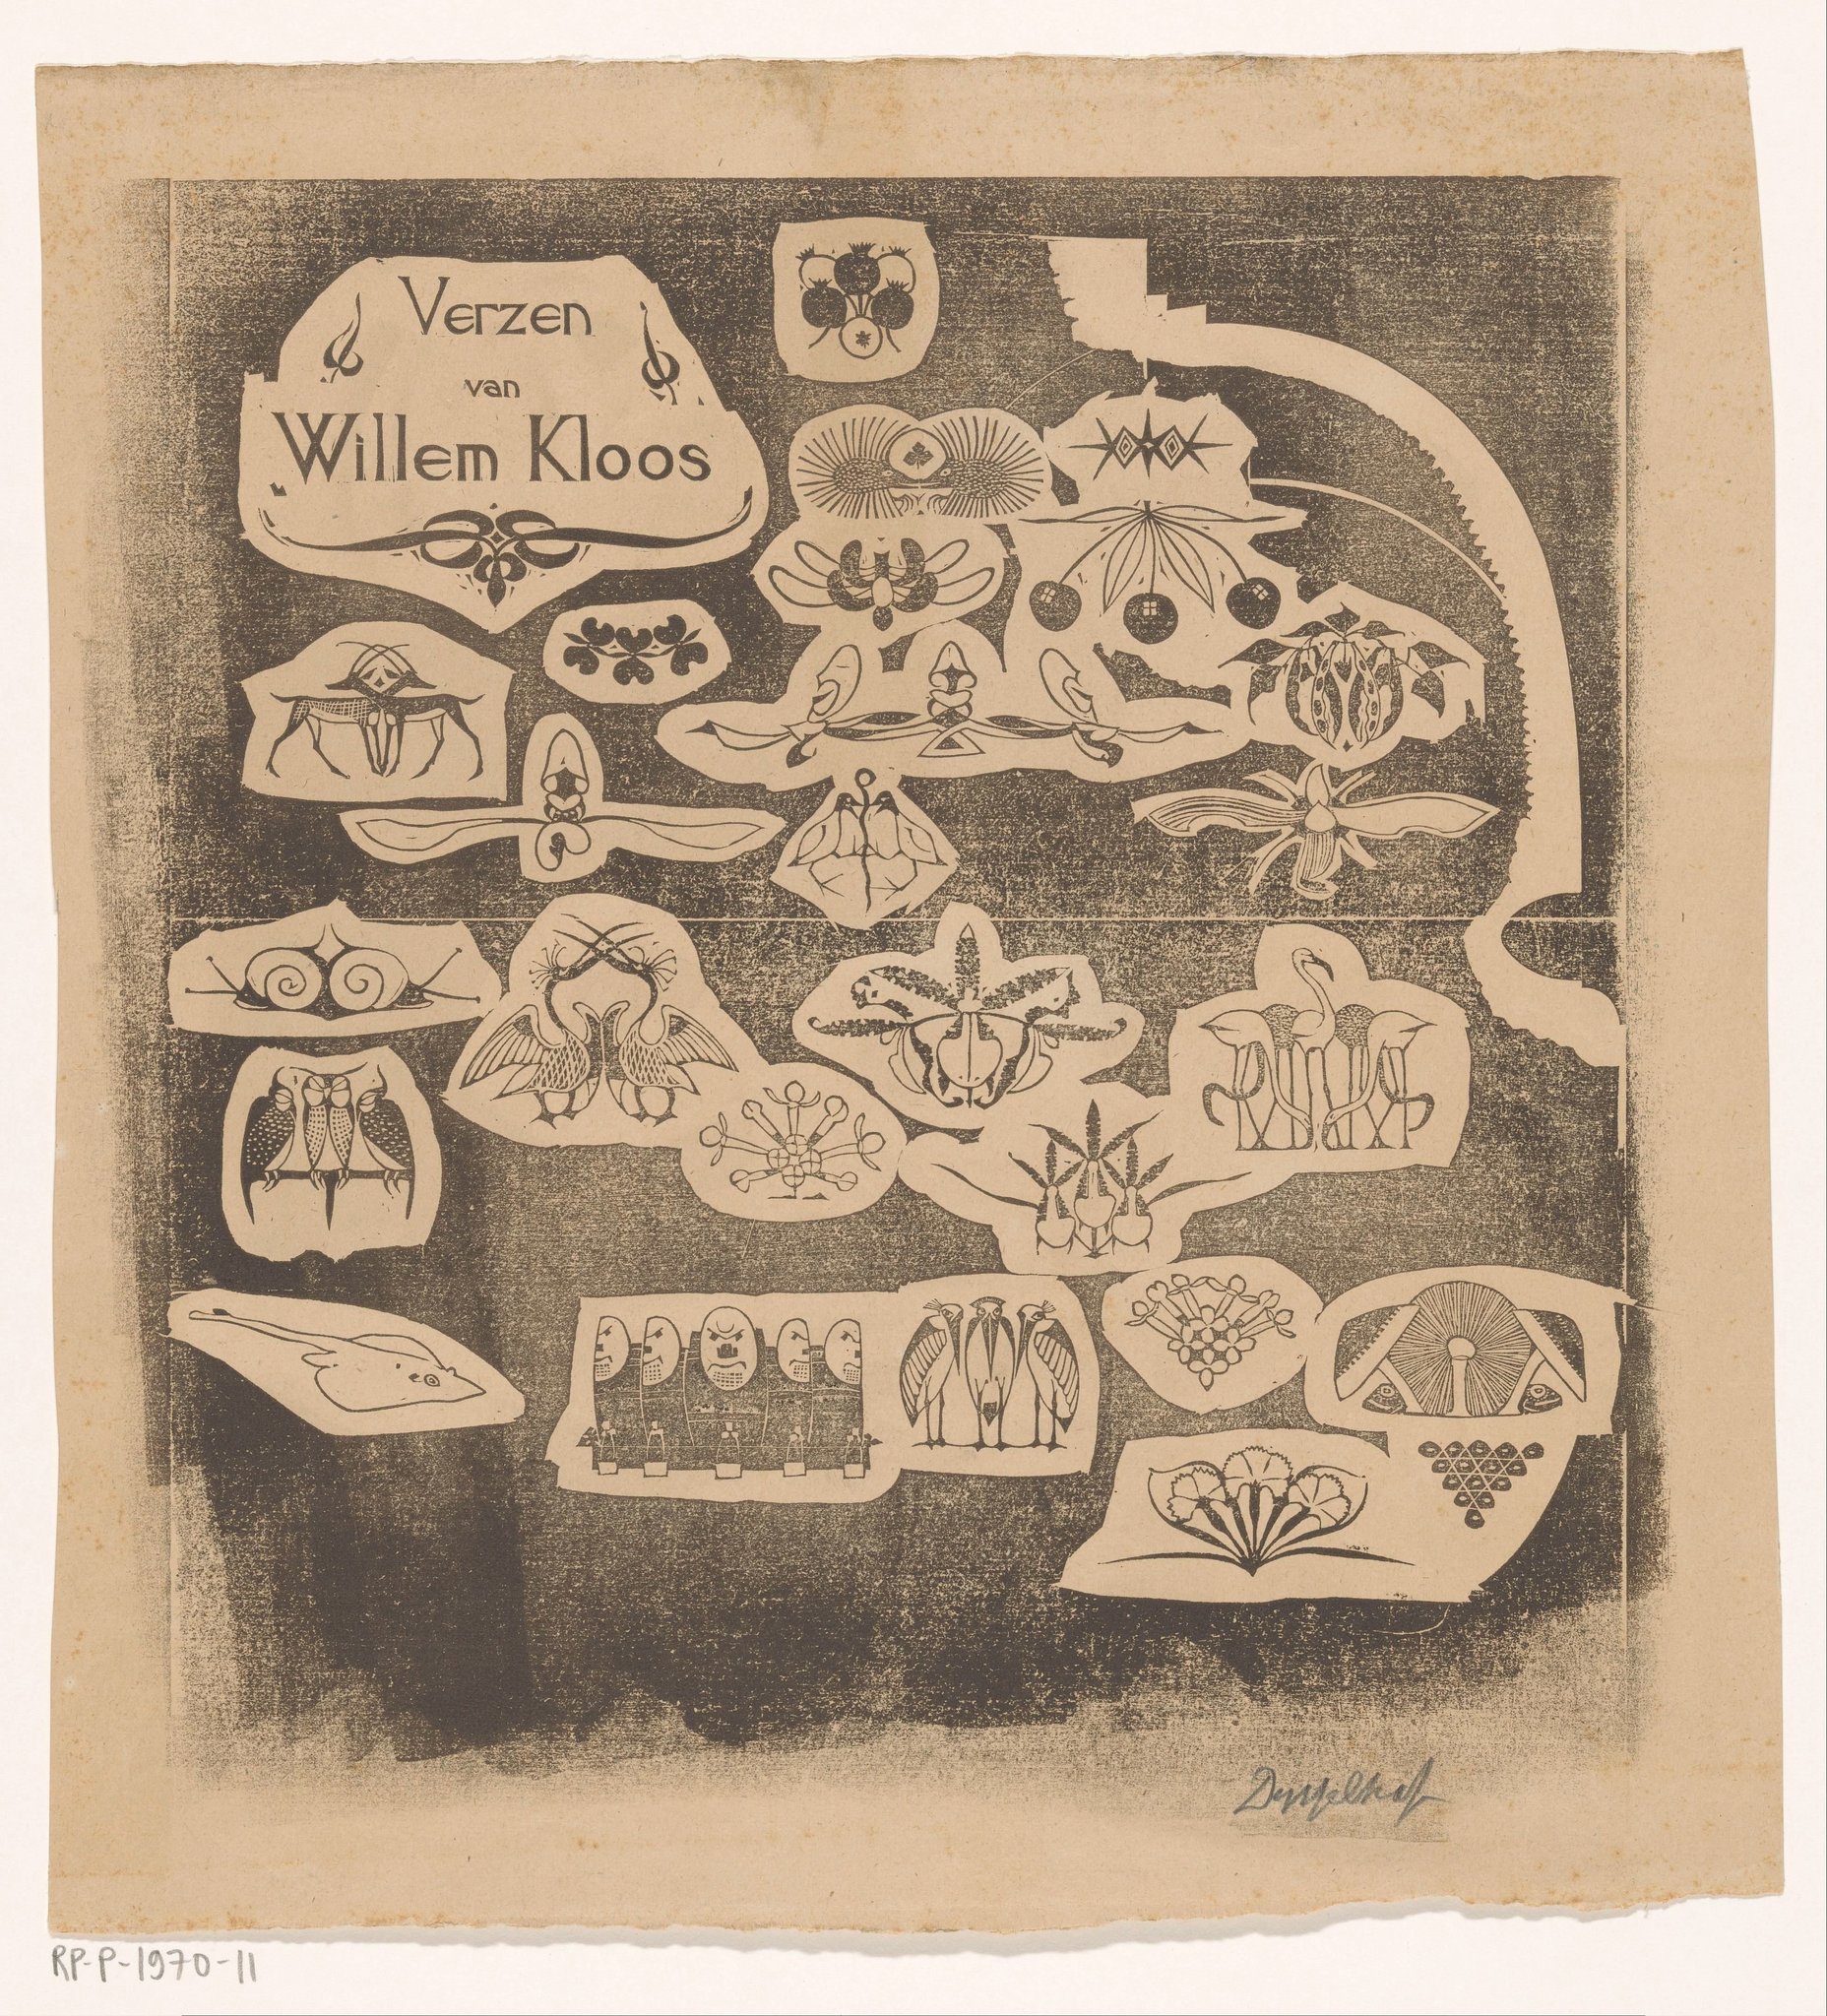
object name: print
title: Zevenentwintig vignetten voor 'Verzen' van Willem Kloos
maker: gerrit willem dijsselhof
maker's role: designer, draughtsman, print maker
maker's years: 1866-1924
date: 1892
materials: paper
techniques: woodcut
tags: plants (in general), animals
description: Gerrit Willem Dijsselhof vervaardigde deze zevenentwintig vignetten voor de gedichtenbundel 'Verzen' van Willem Kloos, die zou verschijnen bij de uitgeverij W. Versluys. Hoewel de uitvoering van het boek in een ver stadium was, is het uiteindelijk nooit verschenen. De vignetten zijn later wel voor diverse andere doeleinden gebruikt.